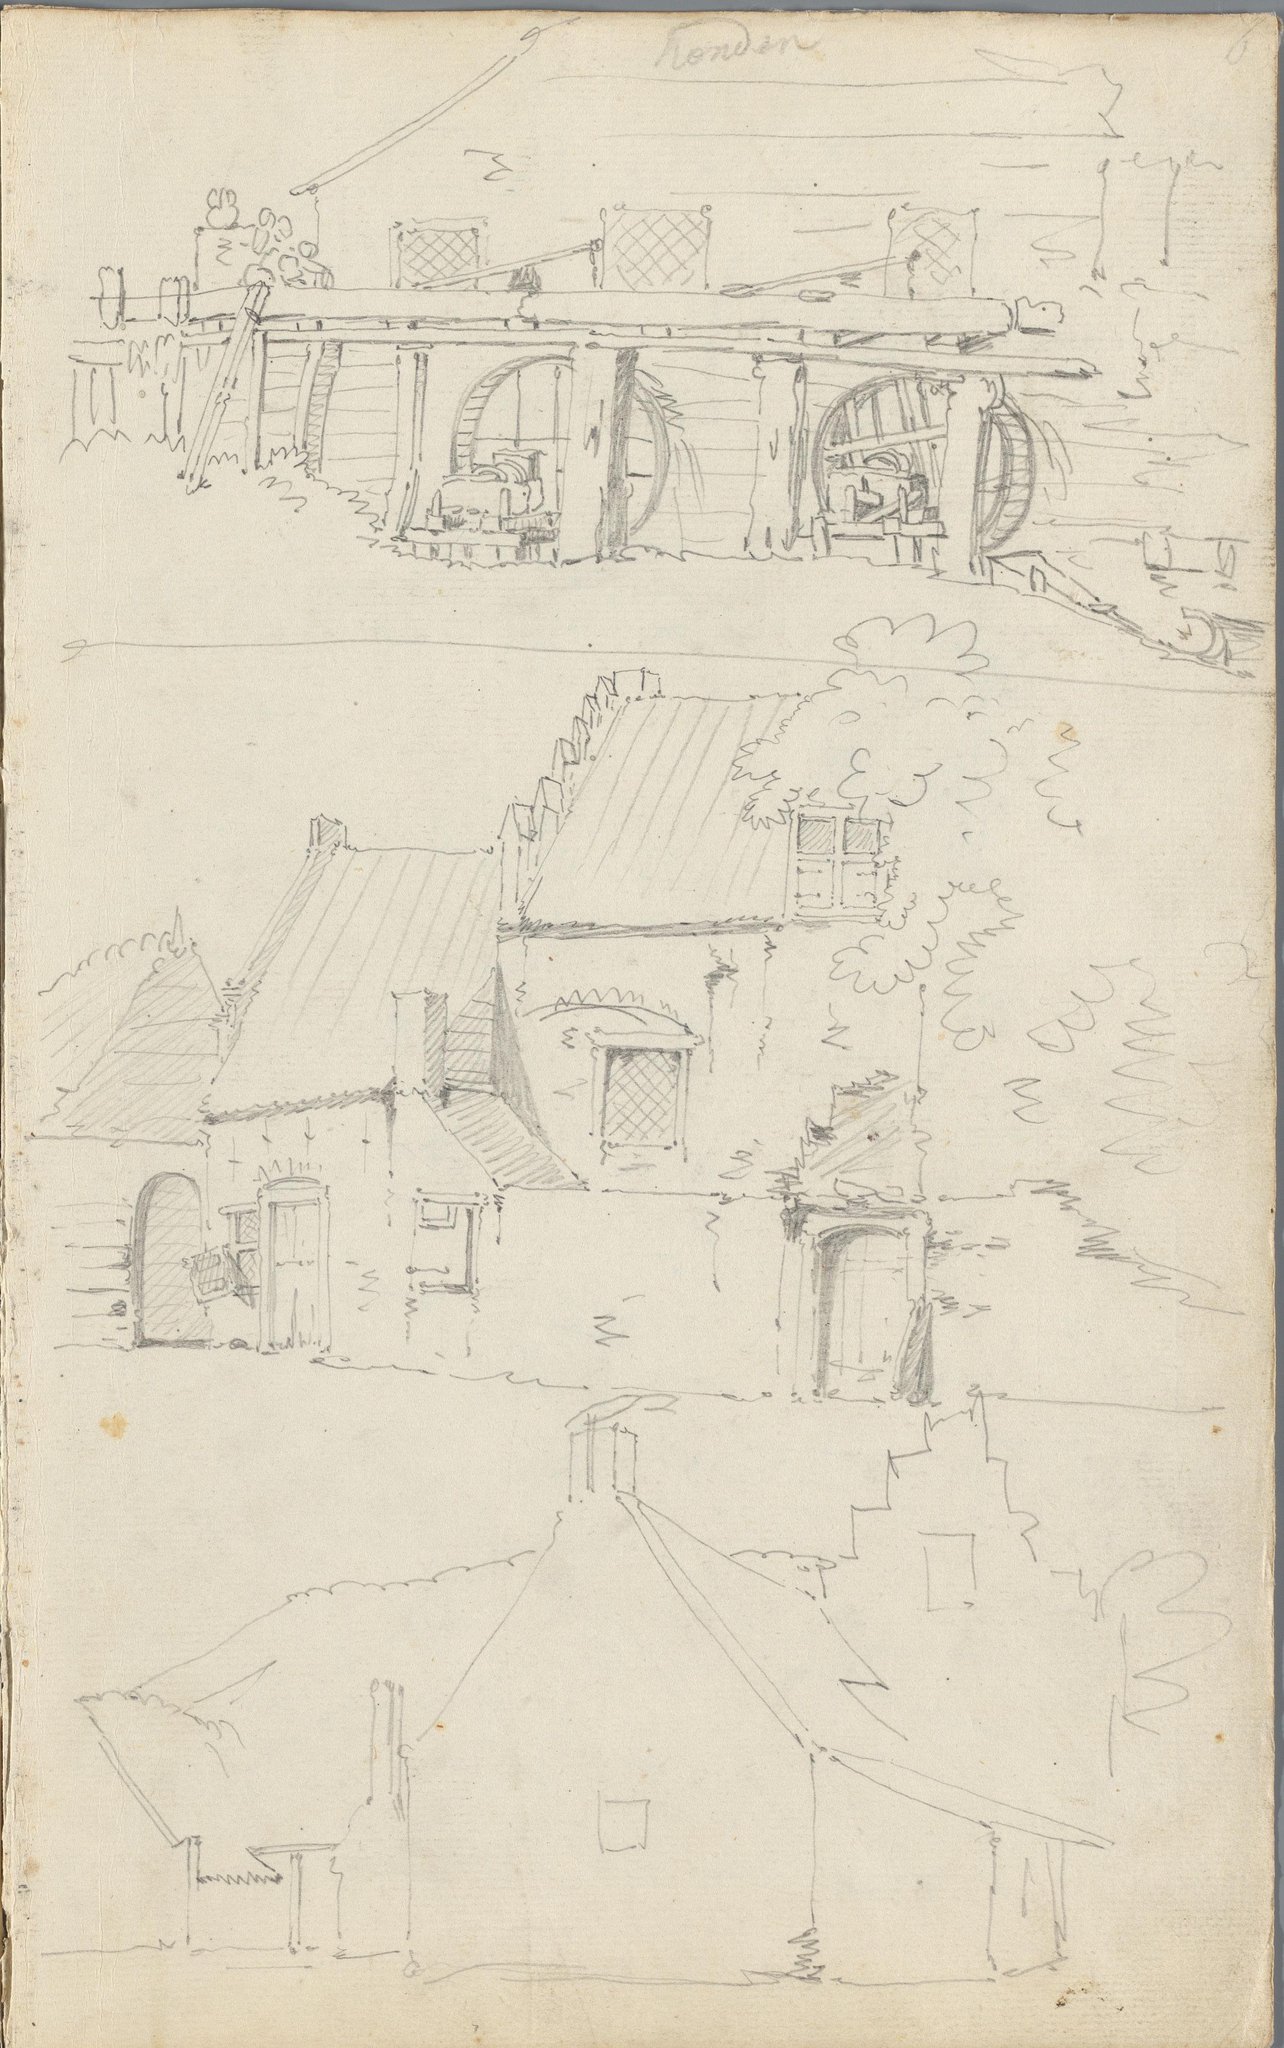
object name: sketchbook leaf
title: Boerderijen en een watermolen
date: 1780-1800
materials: paper, pencil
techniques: drawing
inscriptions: inscription: ‘Londen’, inscription: ‘6’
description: Blad 14 recto uit een schetsboek met 17 bladen.